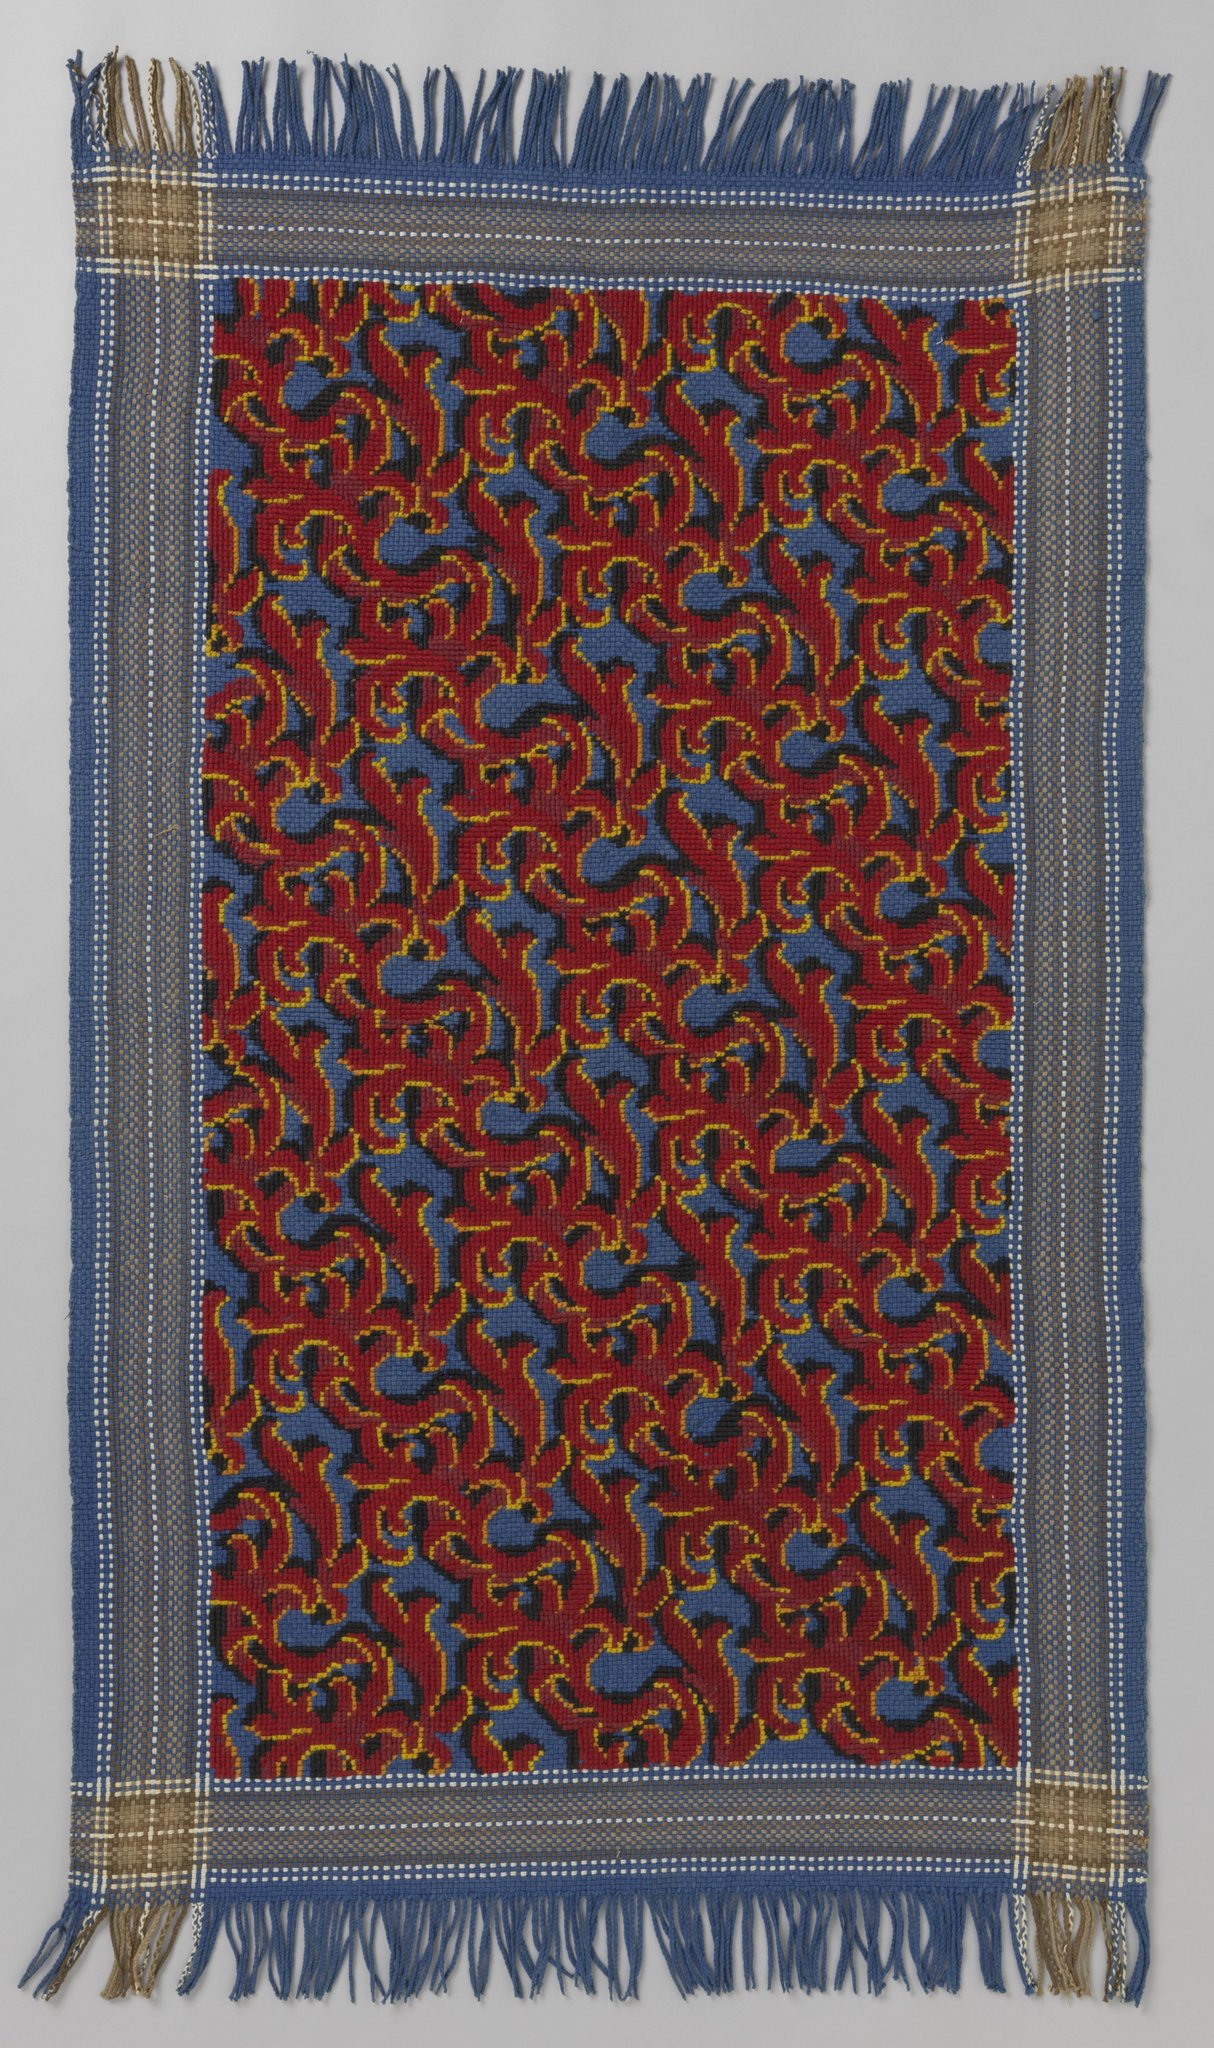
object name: runner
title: Geborduurd kleed of loper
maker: Anonymous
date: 1820-1850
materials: cotton, wool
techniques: embroidered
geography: netherlands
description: Loper, geweven in wit blauw, bruin, mokka en geborduurd in rood, oranje, geel en zwart, met franje aan de uiteinden en gevoerd met geglansde blauwe katoen, doorgestikt.